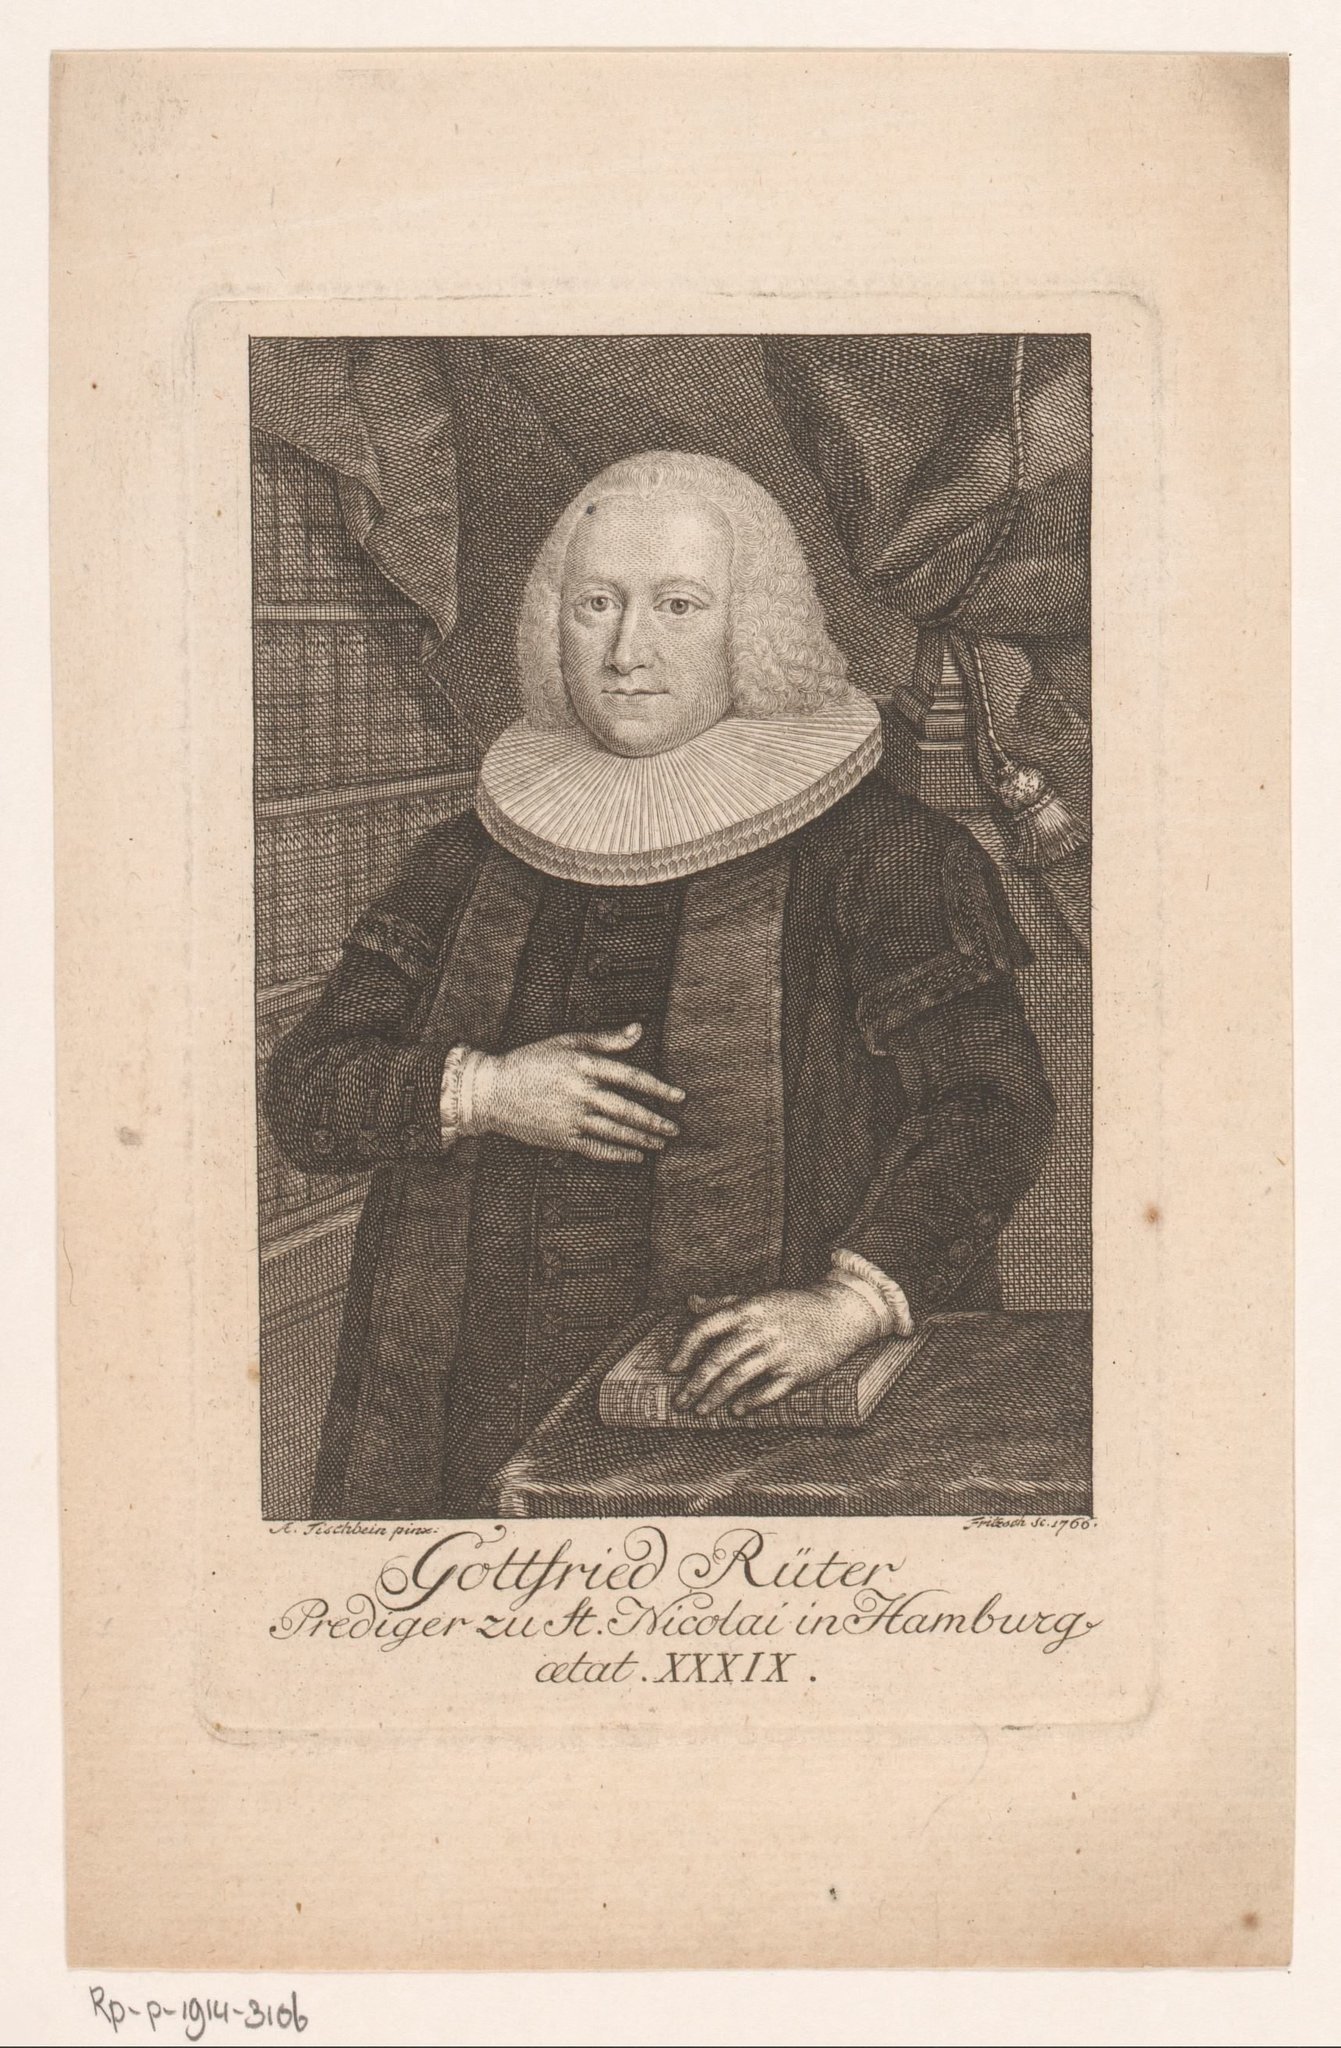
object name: print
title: Portret van Gottfried Rüter op 39-jarige leeftijd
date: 1766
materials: paper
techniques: engraving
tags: bookshelves, historical persons, book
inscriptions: collector's mark: Lugt 2228